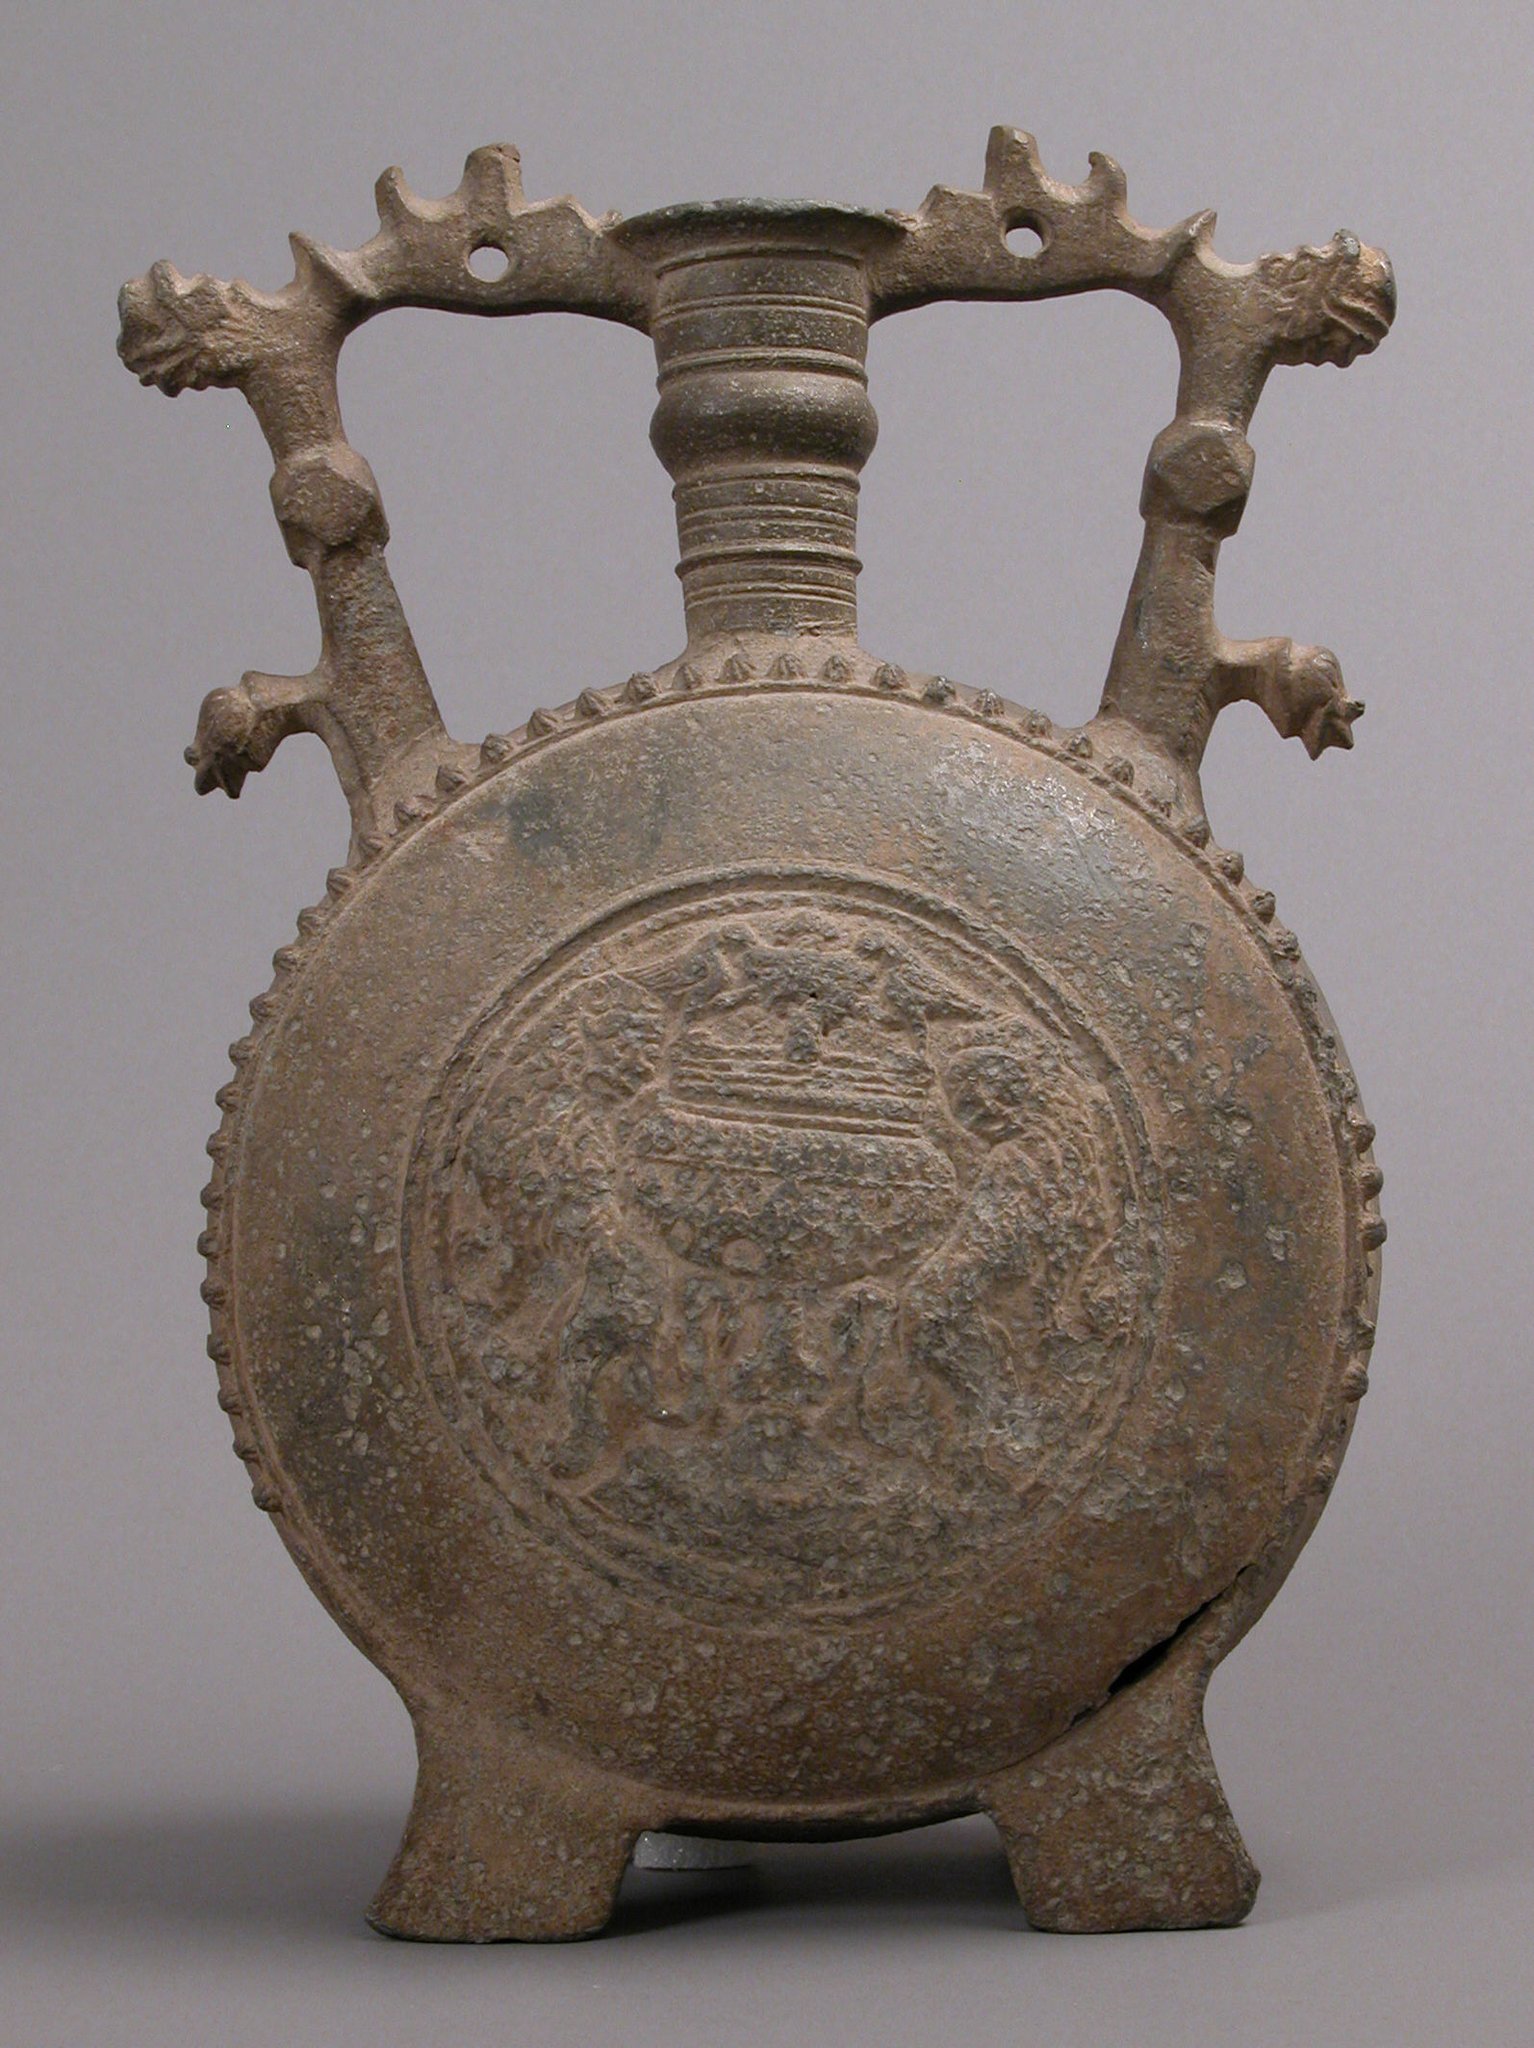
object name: flask with two handle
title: Flask with Handles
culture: balkan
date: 1401-1600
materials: pewter